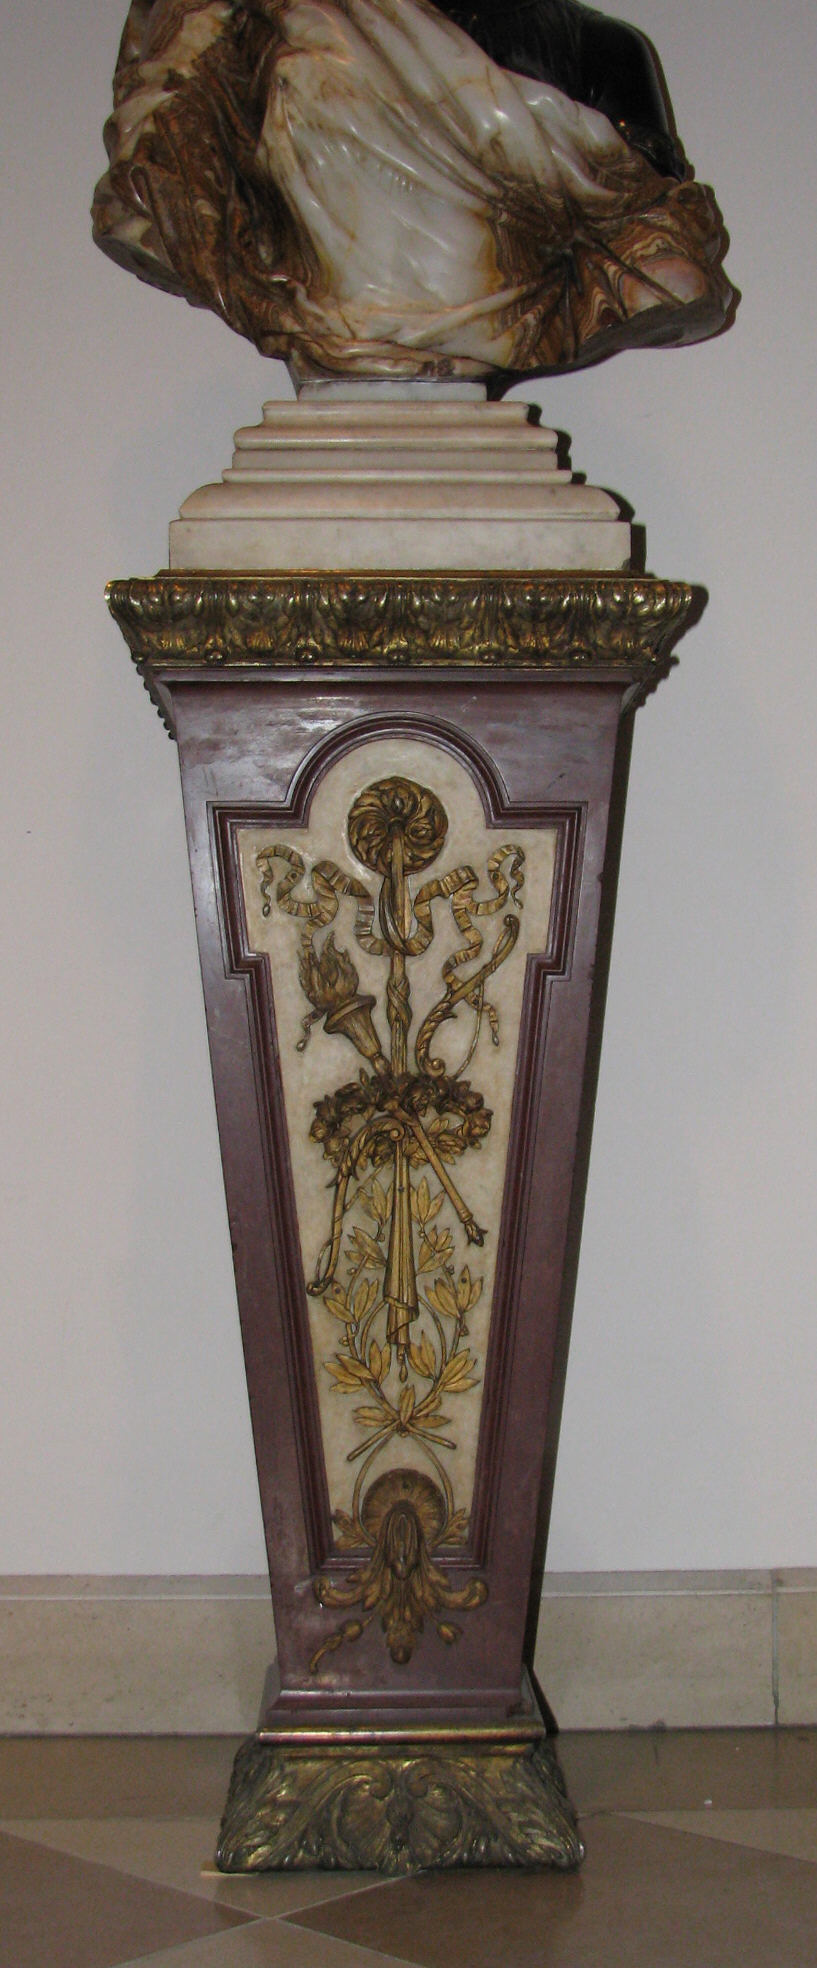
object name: pedestal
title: Pedestal [for Woman from the French Colonies]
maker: charles-henri-joseph cordier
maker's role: artist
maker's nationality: french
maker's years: 1827-1905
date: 1861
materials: gilt bronze, marble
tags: women